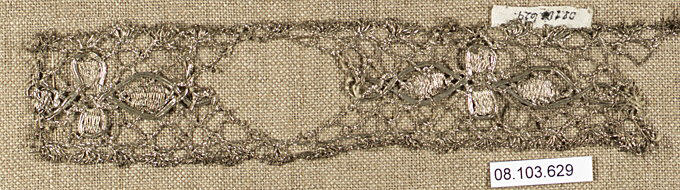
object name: piece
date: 1701-1800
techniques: lace